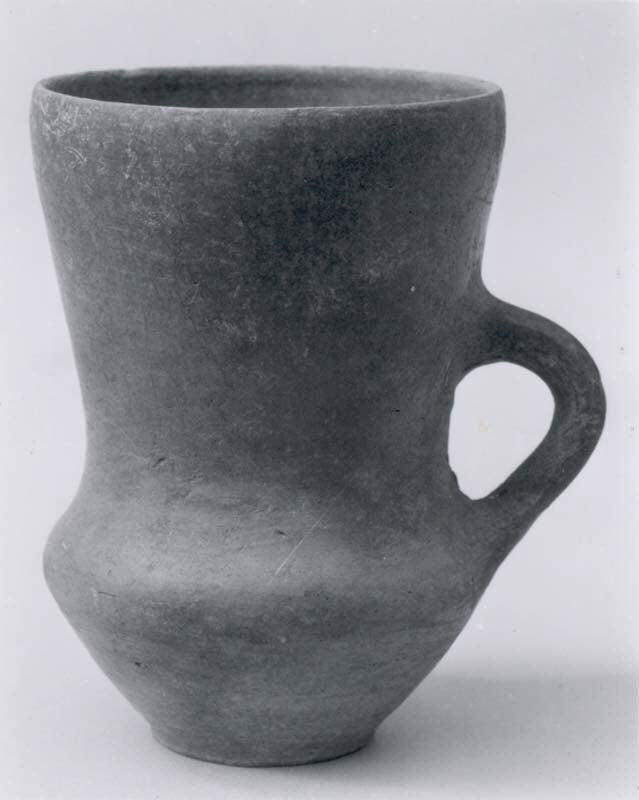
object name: jar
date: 2000-1001 BCE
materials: ceramic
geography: iran